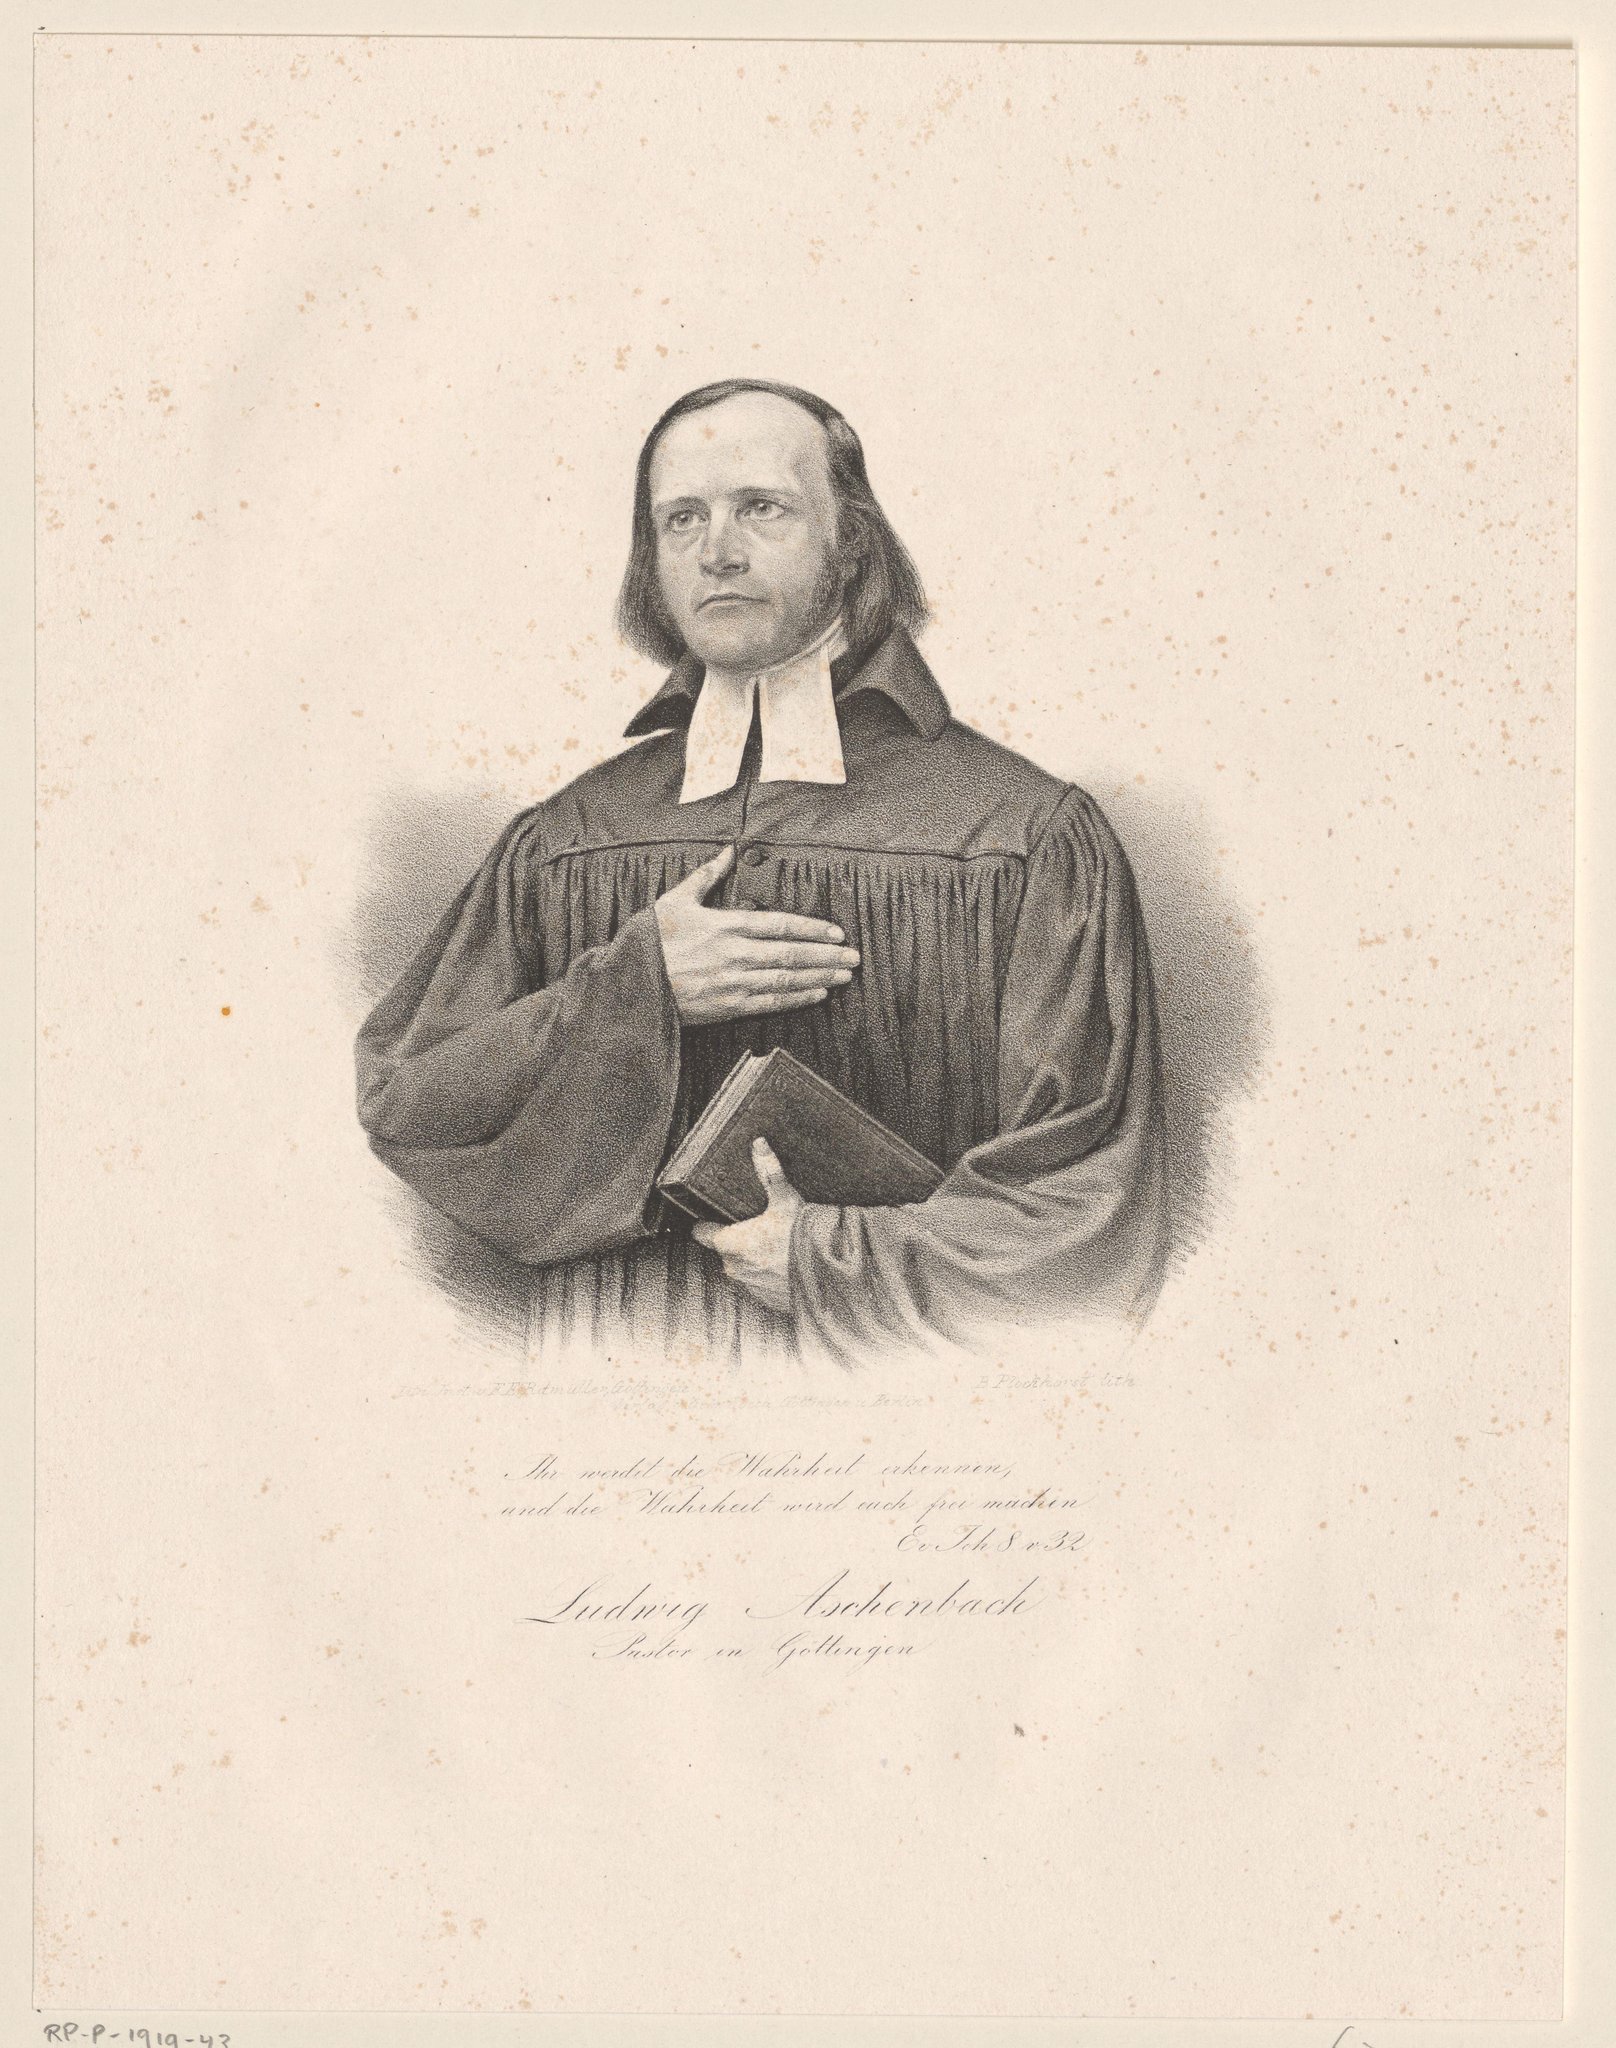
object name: print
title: Portret van Ludwig Aschenbach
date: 1835-1874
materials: paper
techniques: lithograph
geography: berlin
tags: historical persons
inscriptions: collector's mark: Lugt 2228